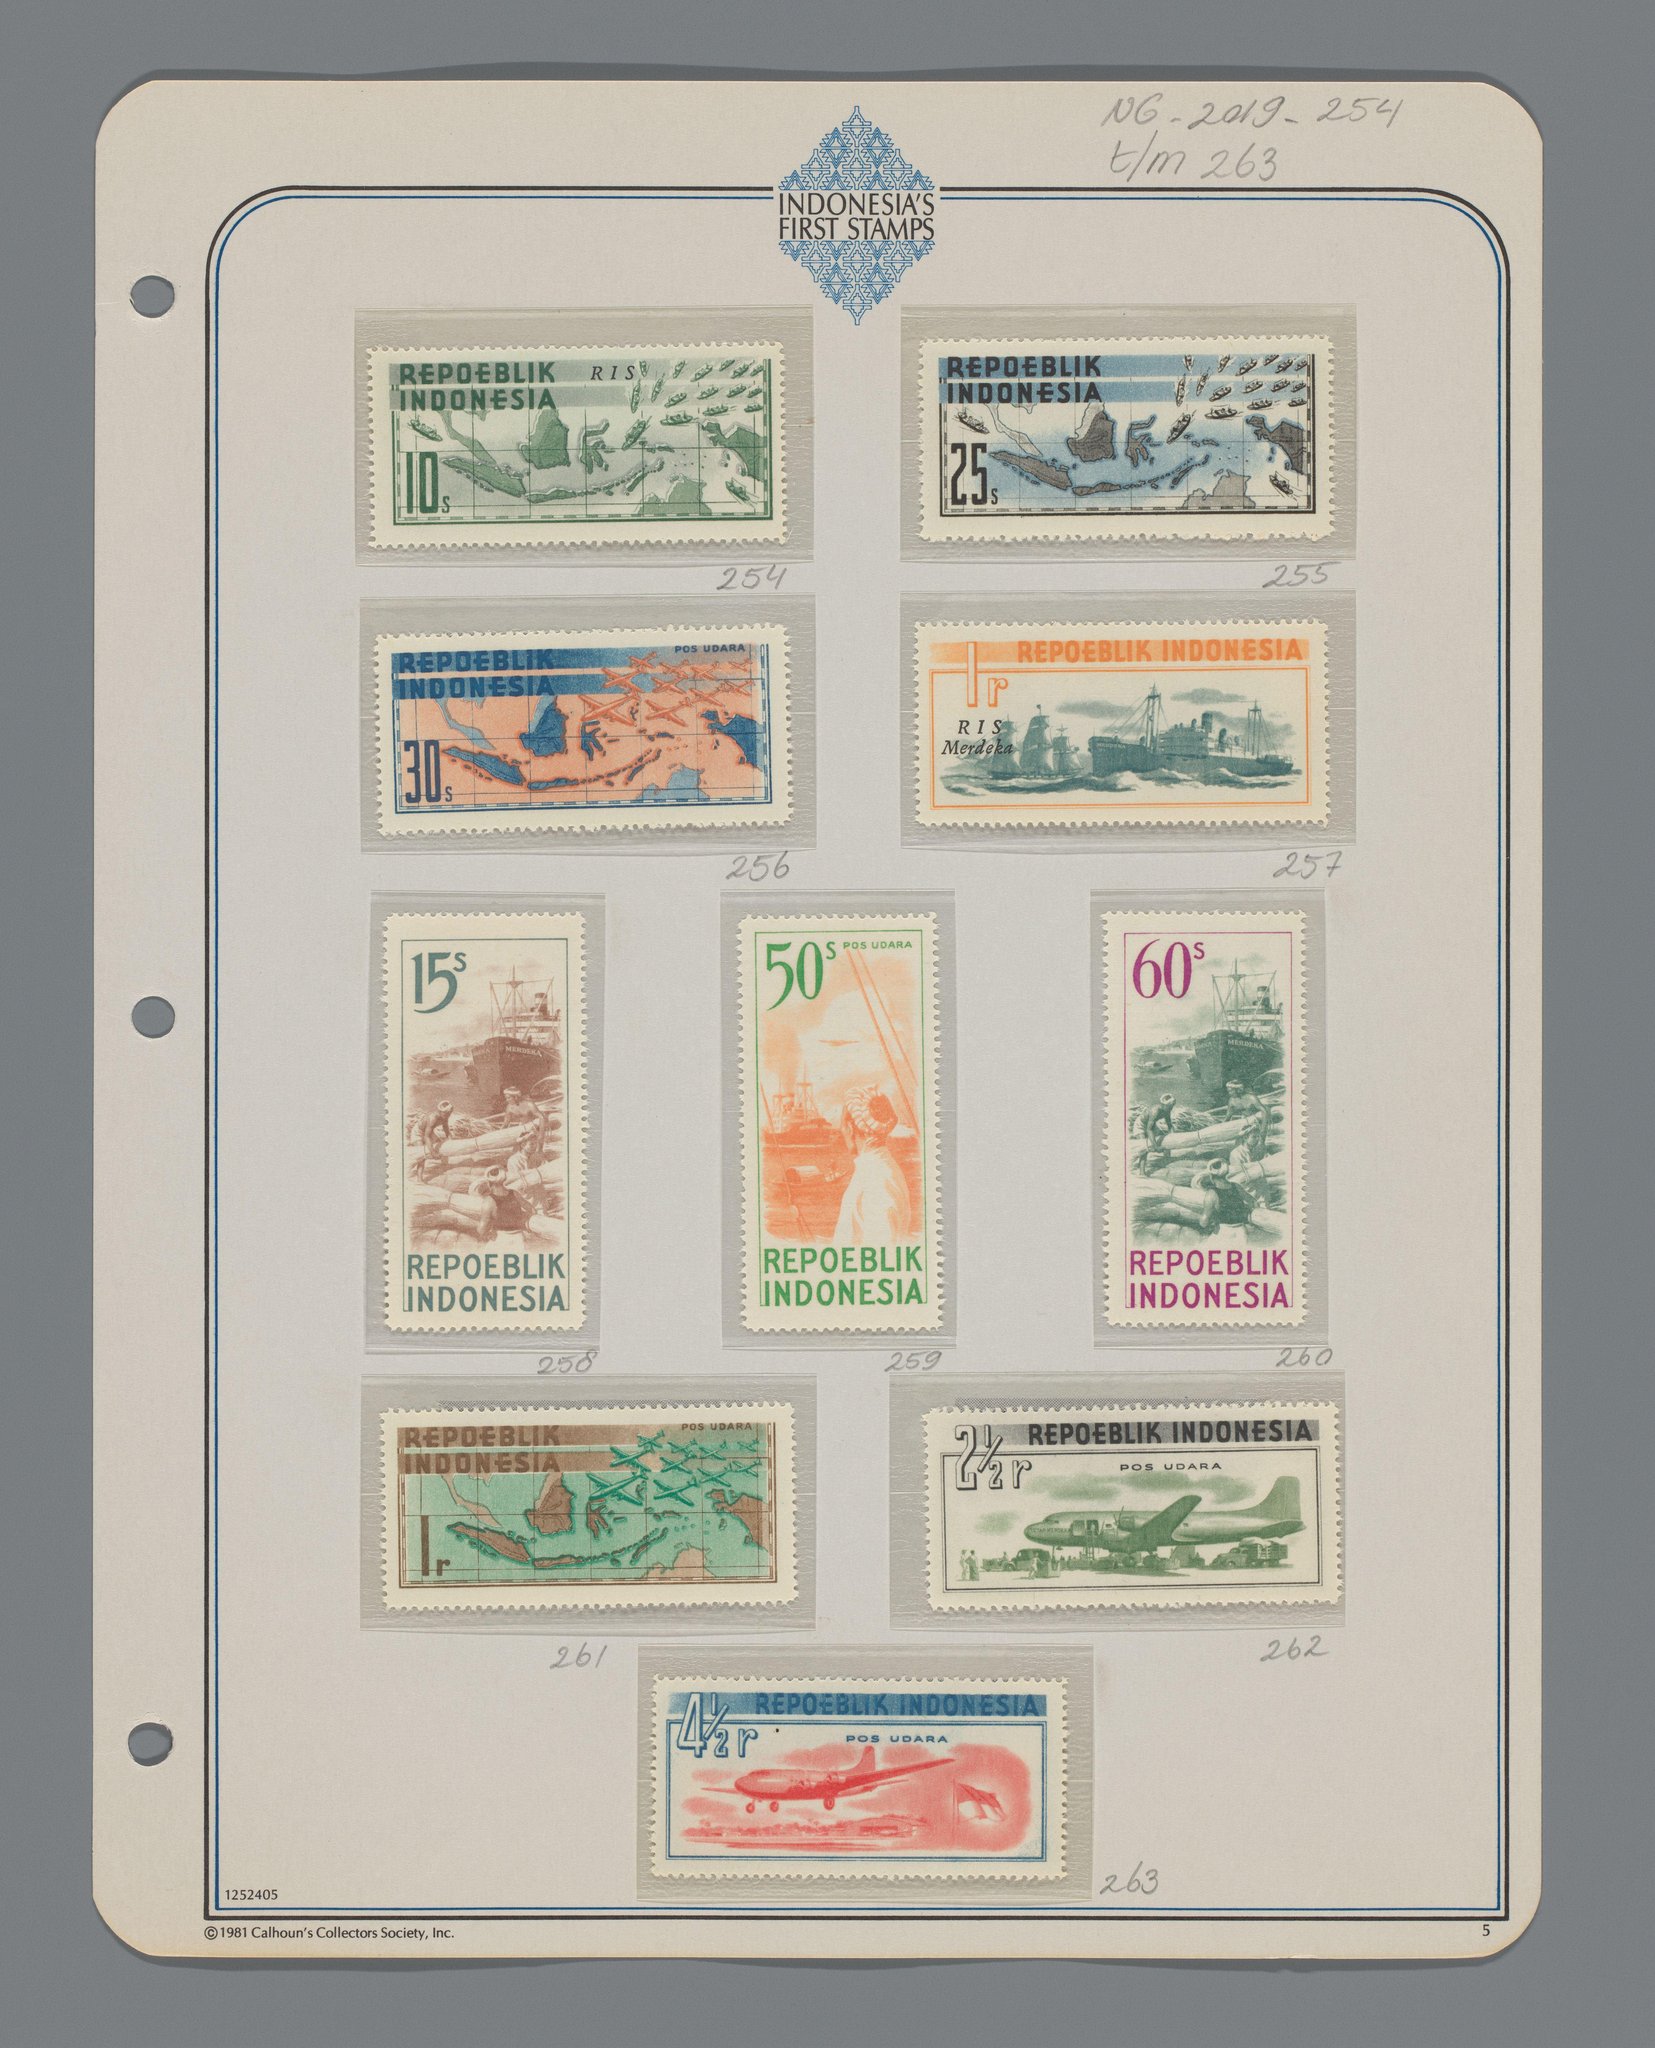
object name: postage stamp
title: Postzegel Republik Indonesia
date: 1949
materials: paper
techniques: photoaquatint, engraving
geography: philadelphia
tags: indonesia